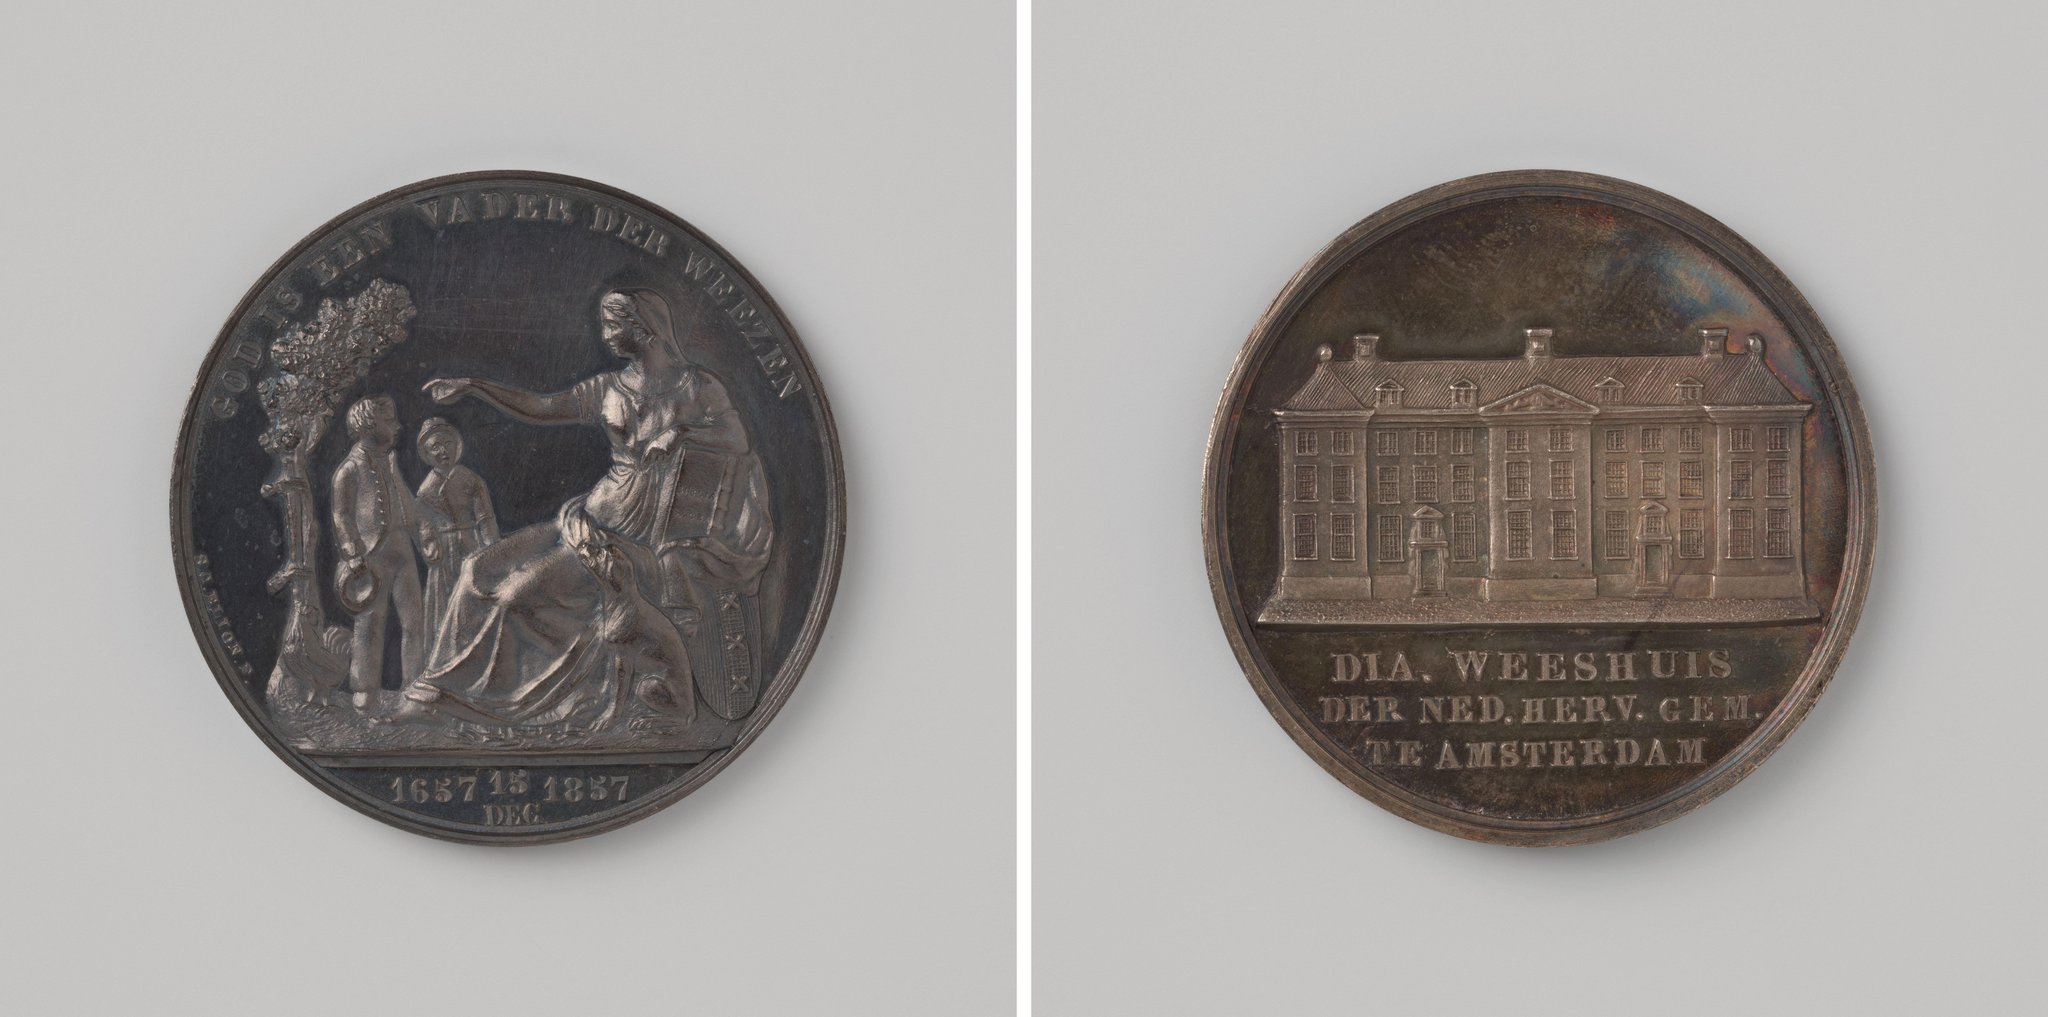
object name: history medal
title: Tweehonderdjarig bestaan van het Diaconie Weeshuis van de Nederduitsche Hervormde Gemeente te Amsterdam 1857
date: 1857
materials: silver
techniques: striking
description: Zilveren penning, op de voorzijde de Liefdadigheid als zittende vrouw met bijbel en hond, links twee wezen onder een gestutte jonge boom, met omschrift en afsnedetekst, op de keerzijde het vooraanzicht van het weeshuis boven drie regels tekst.